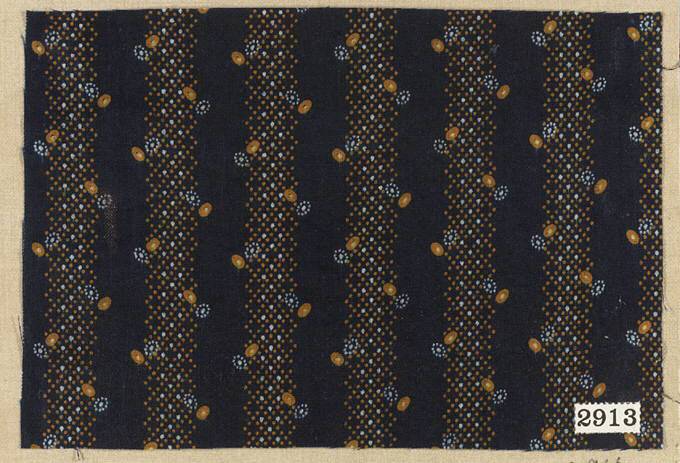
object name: piece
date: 1801-1900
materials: cotton